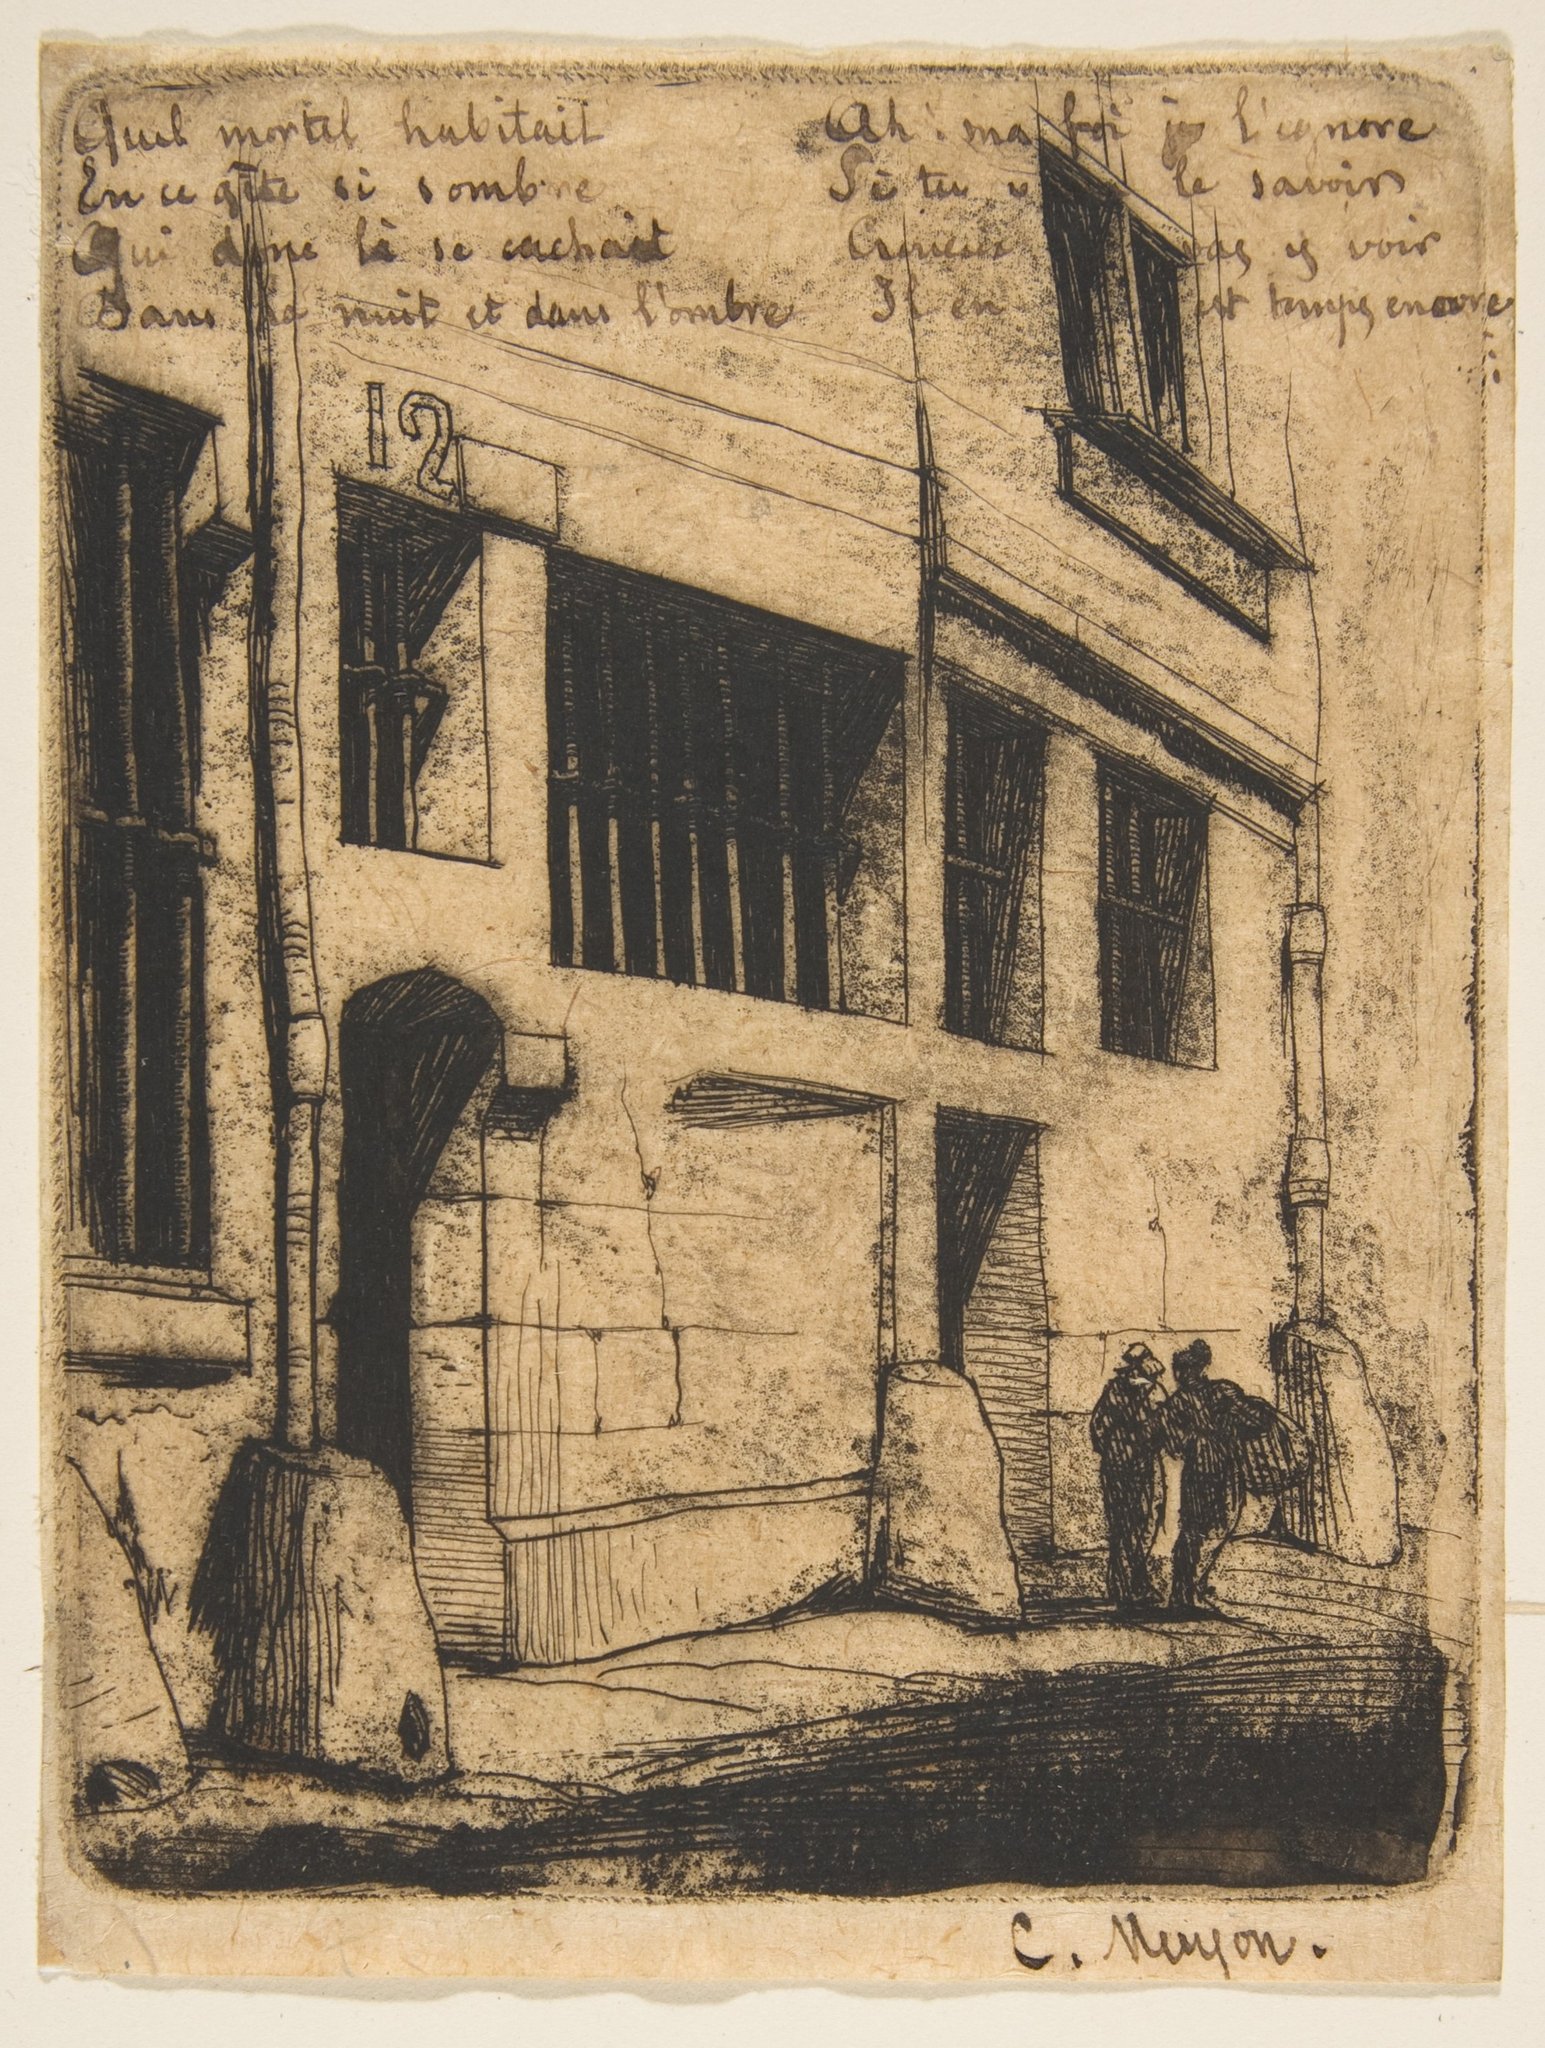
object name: print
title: Rue des Mauvais Garçons, Paris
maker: charles meryon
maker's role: artist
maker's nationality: french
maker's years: 1821-1868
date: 1854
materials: ink, paper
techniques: etching, pen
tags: buildings,paris